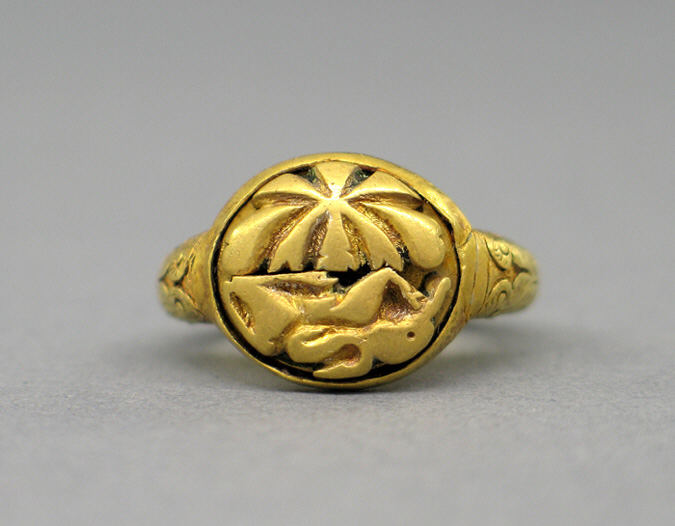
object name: ring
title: Ring with Oval Bezel Depicting Zoomorphic Design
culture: indonesian, javanese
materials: gold